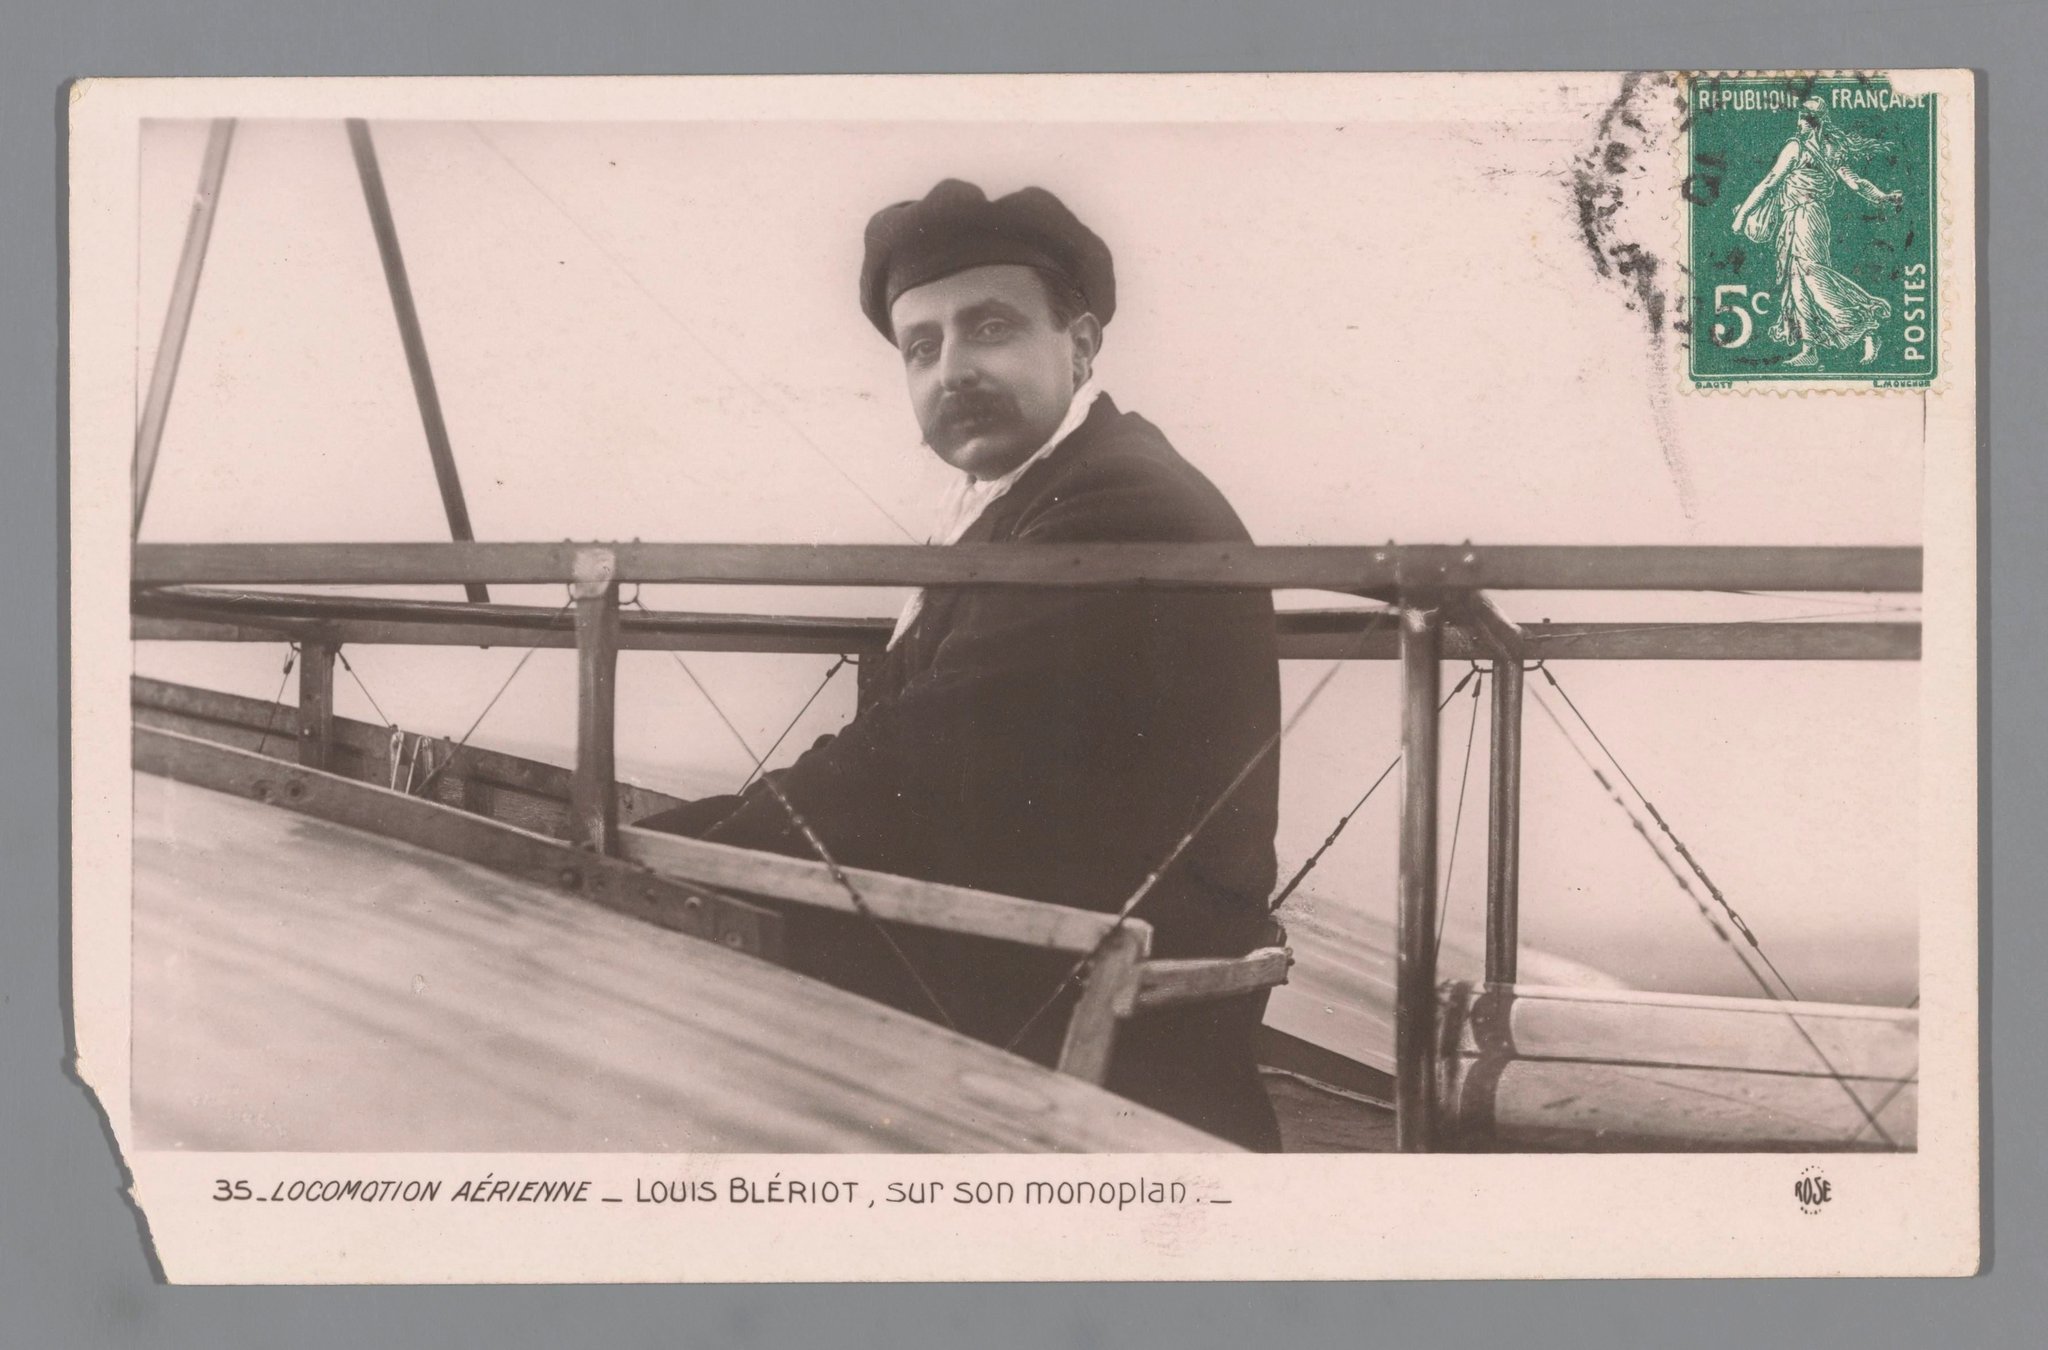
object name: photograph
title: Portret van Louis Blériot op zijn vliegtuig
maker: fr. rose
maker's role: fotograaf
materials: photographic support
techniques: gelatin silver print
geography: france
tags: louis blériot, aircraft, aeroplane, pilot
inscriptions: inscription: ‘7-5-10 (...) Delft (Hollande)’, number: ‘35’